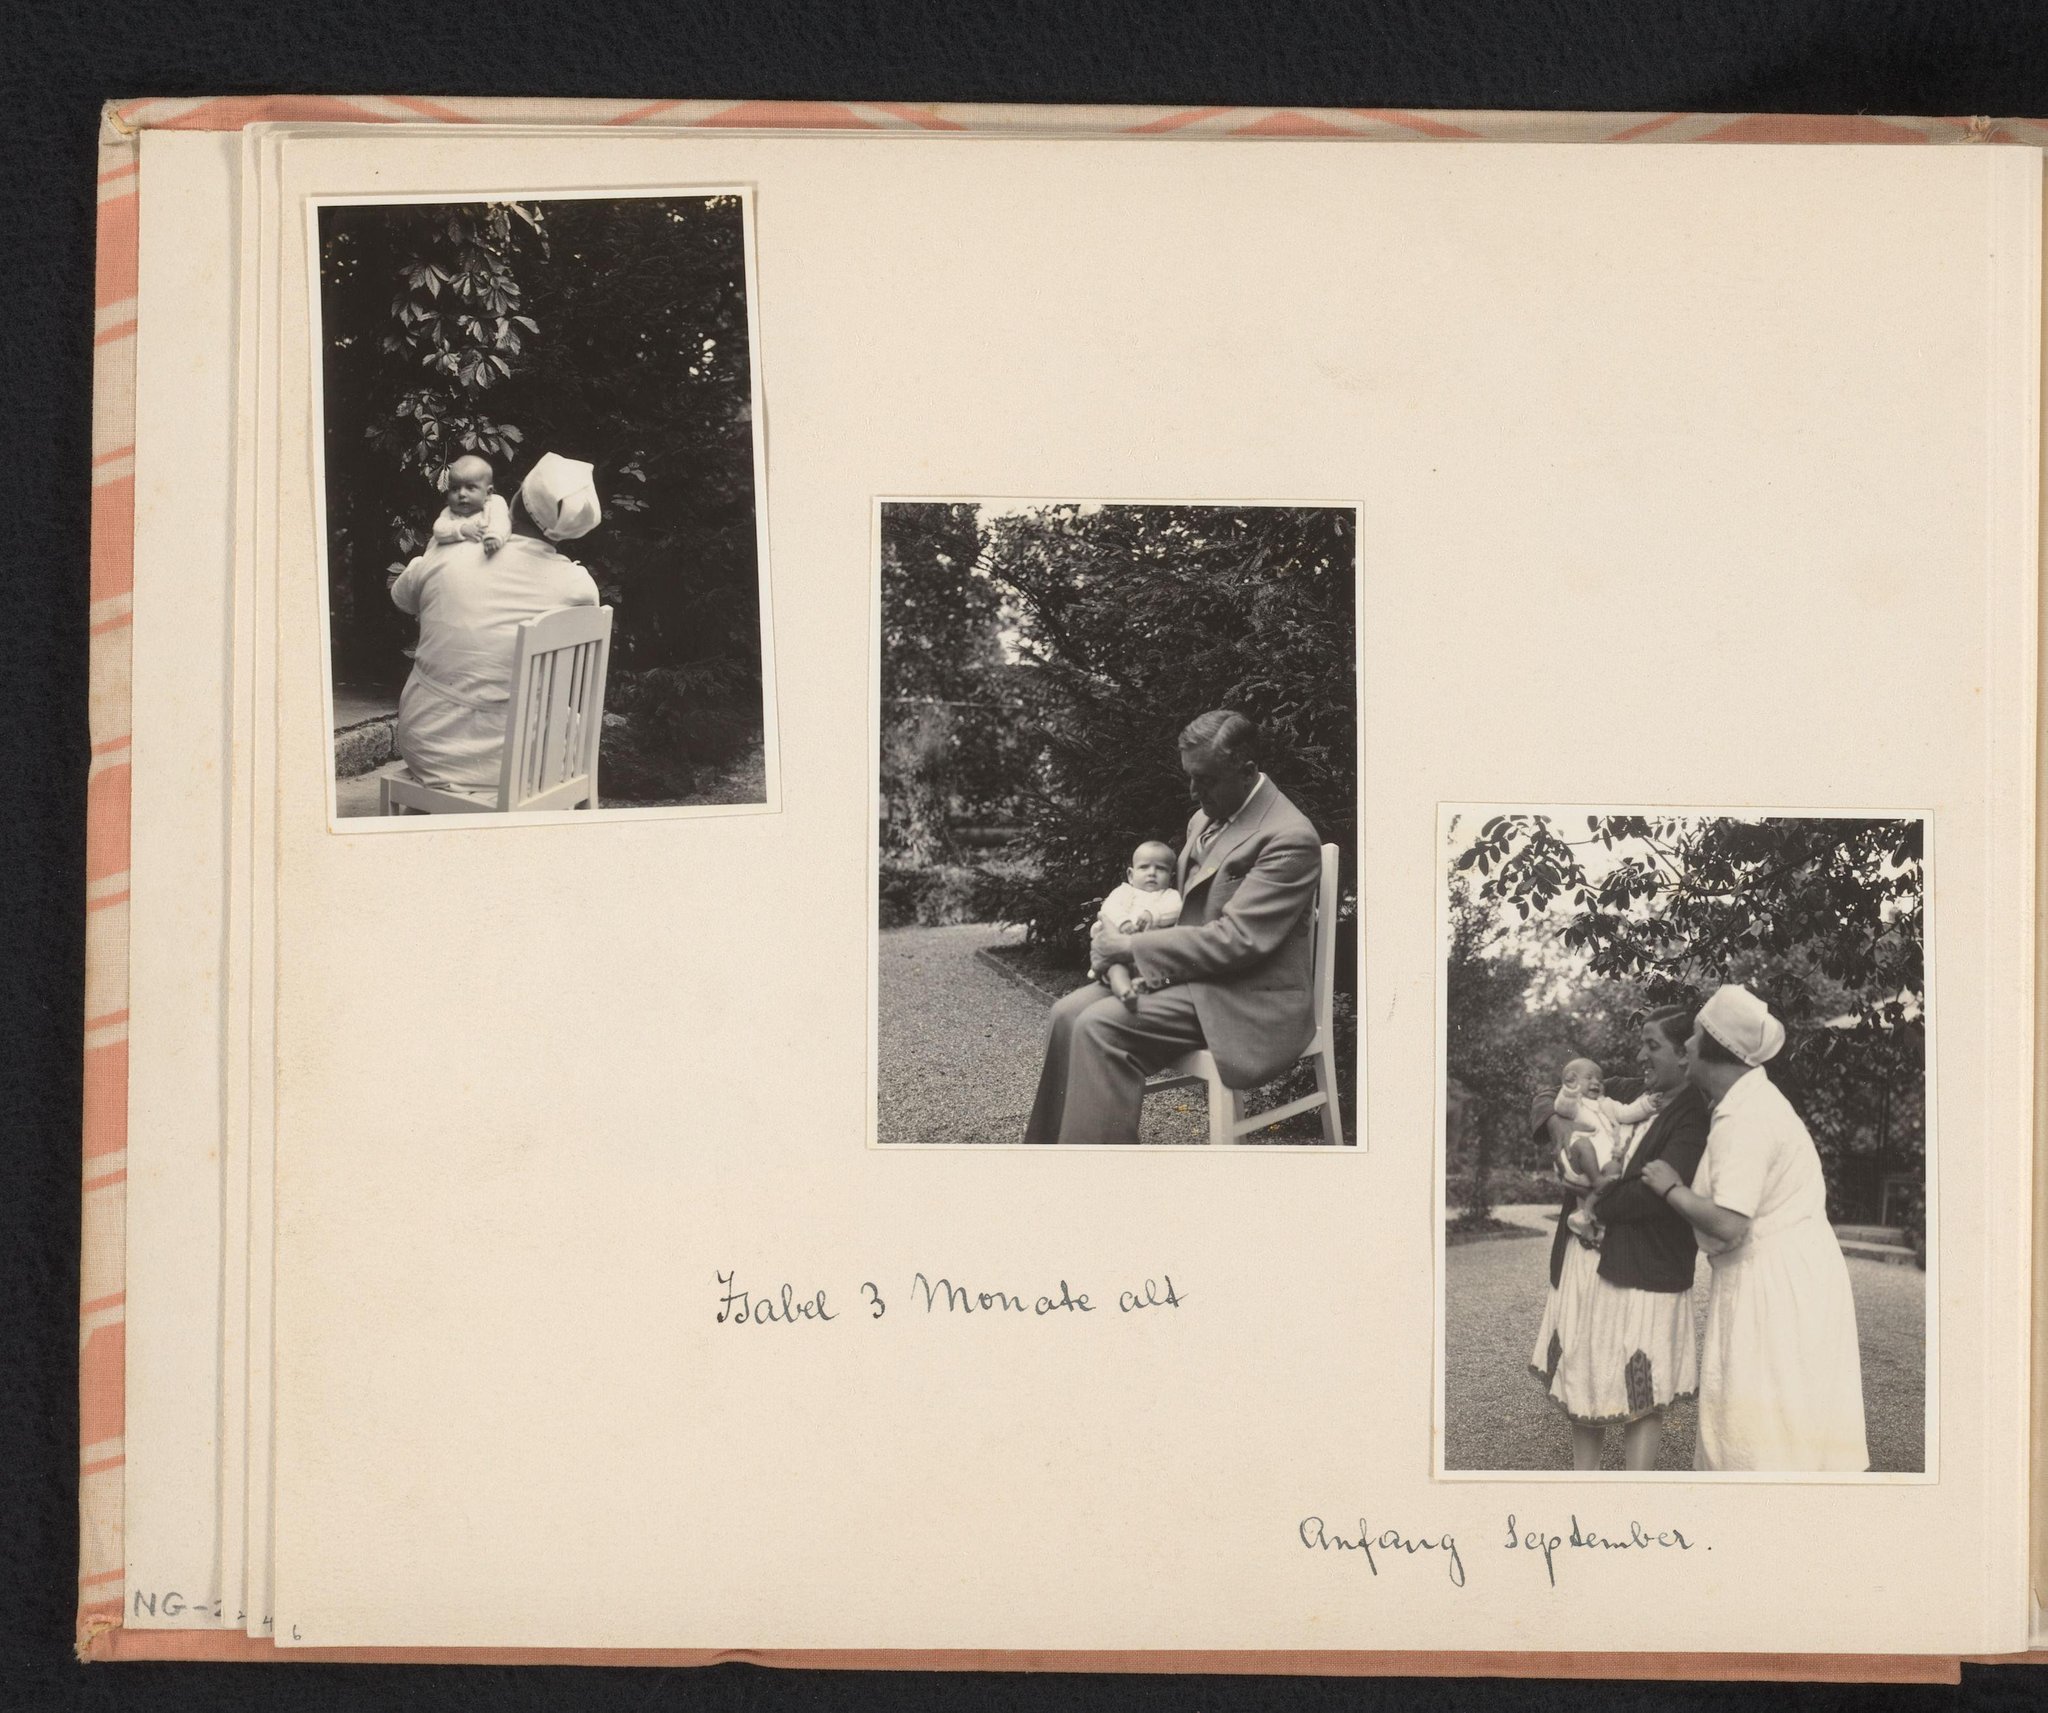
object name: album leaf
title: Isabel Wachenheimer drie maanden oud met haar moeder Else Wachenheimer-Moos, haar vader Eugen Wachenheimer en een onbekende verpleegster, september 1928, Stuttgart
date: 1909-1928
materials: paper, photographic support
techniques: gelatin silver print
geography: stuttgart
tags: eugen wachenheimer, else wachenheimer-moos, leiden, isabel wachenheimer-elon, family life at home, mother and baby or young child, infant, baby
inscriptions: inscription: ‘Isabel 3 Monate alt//Anfang September’